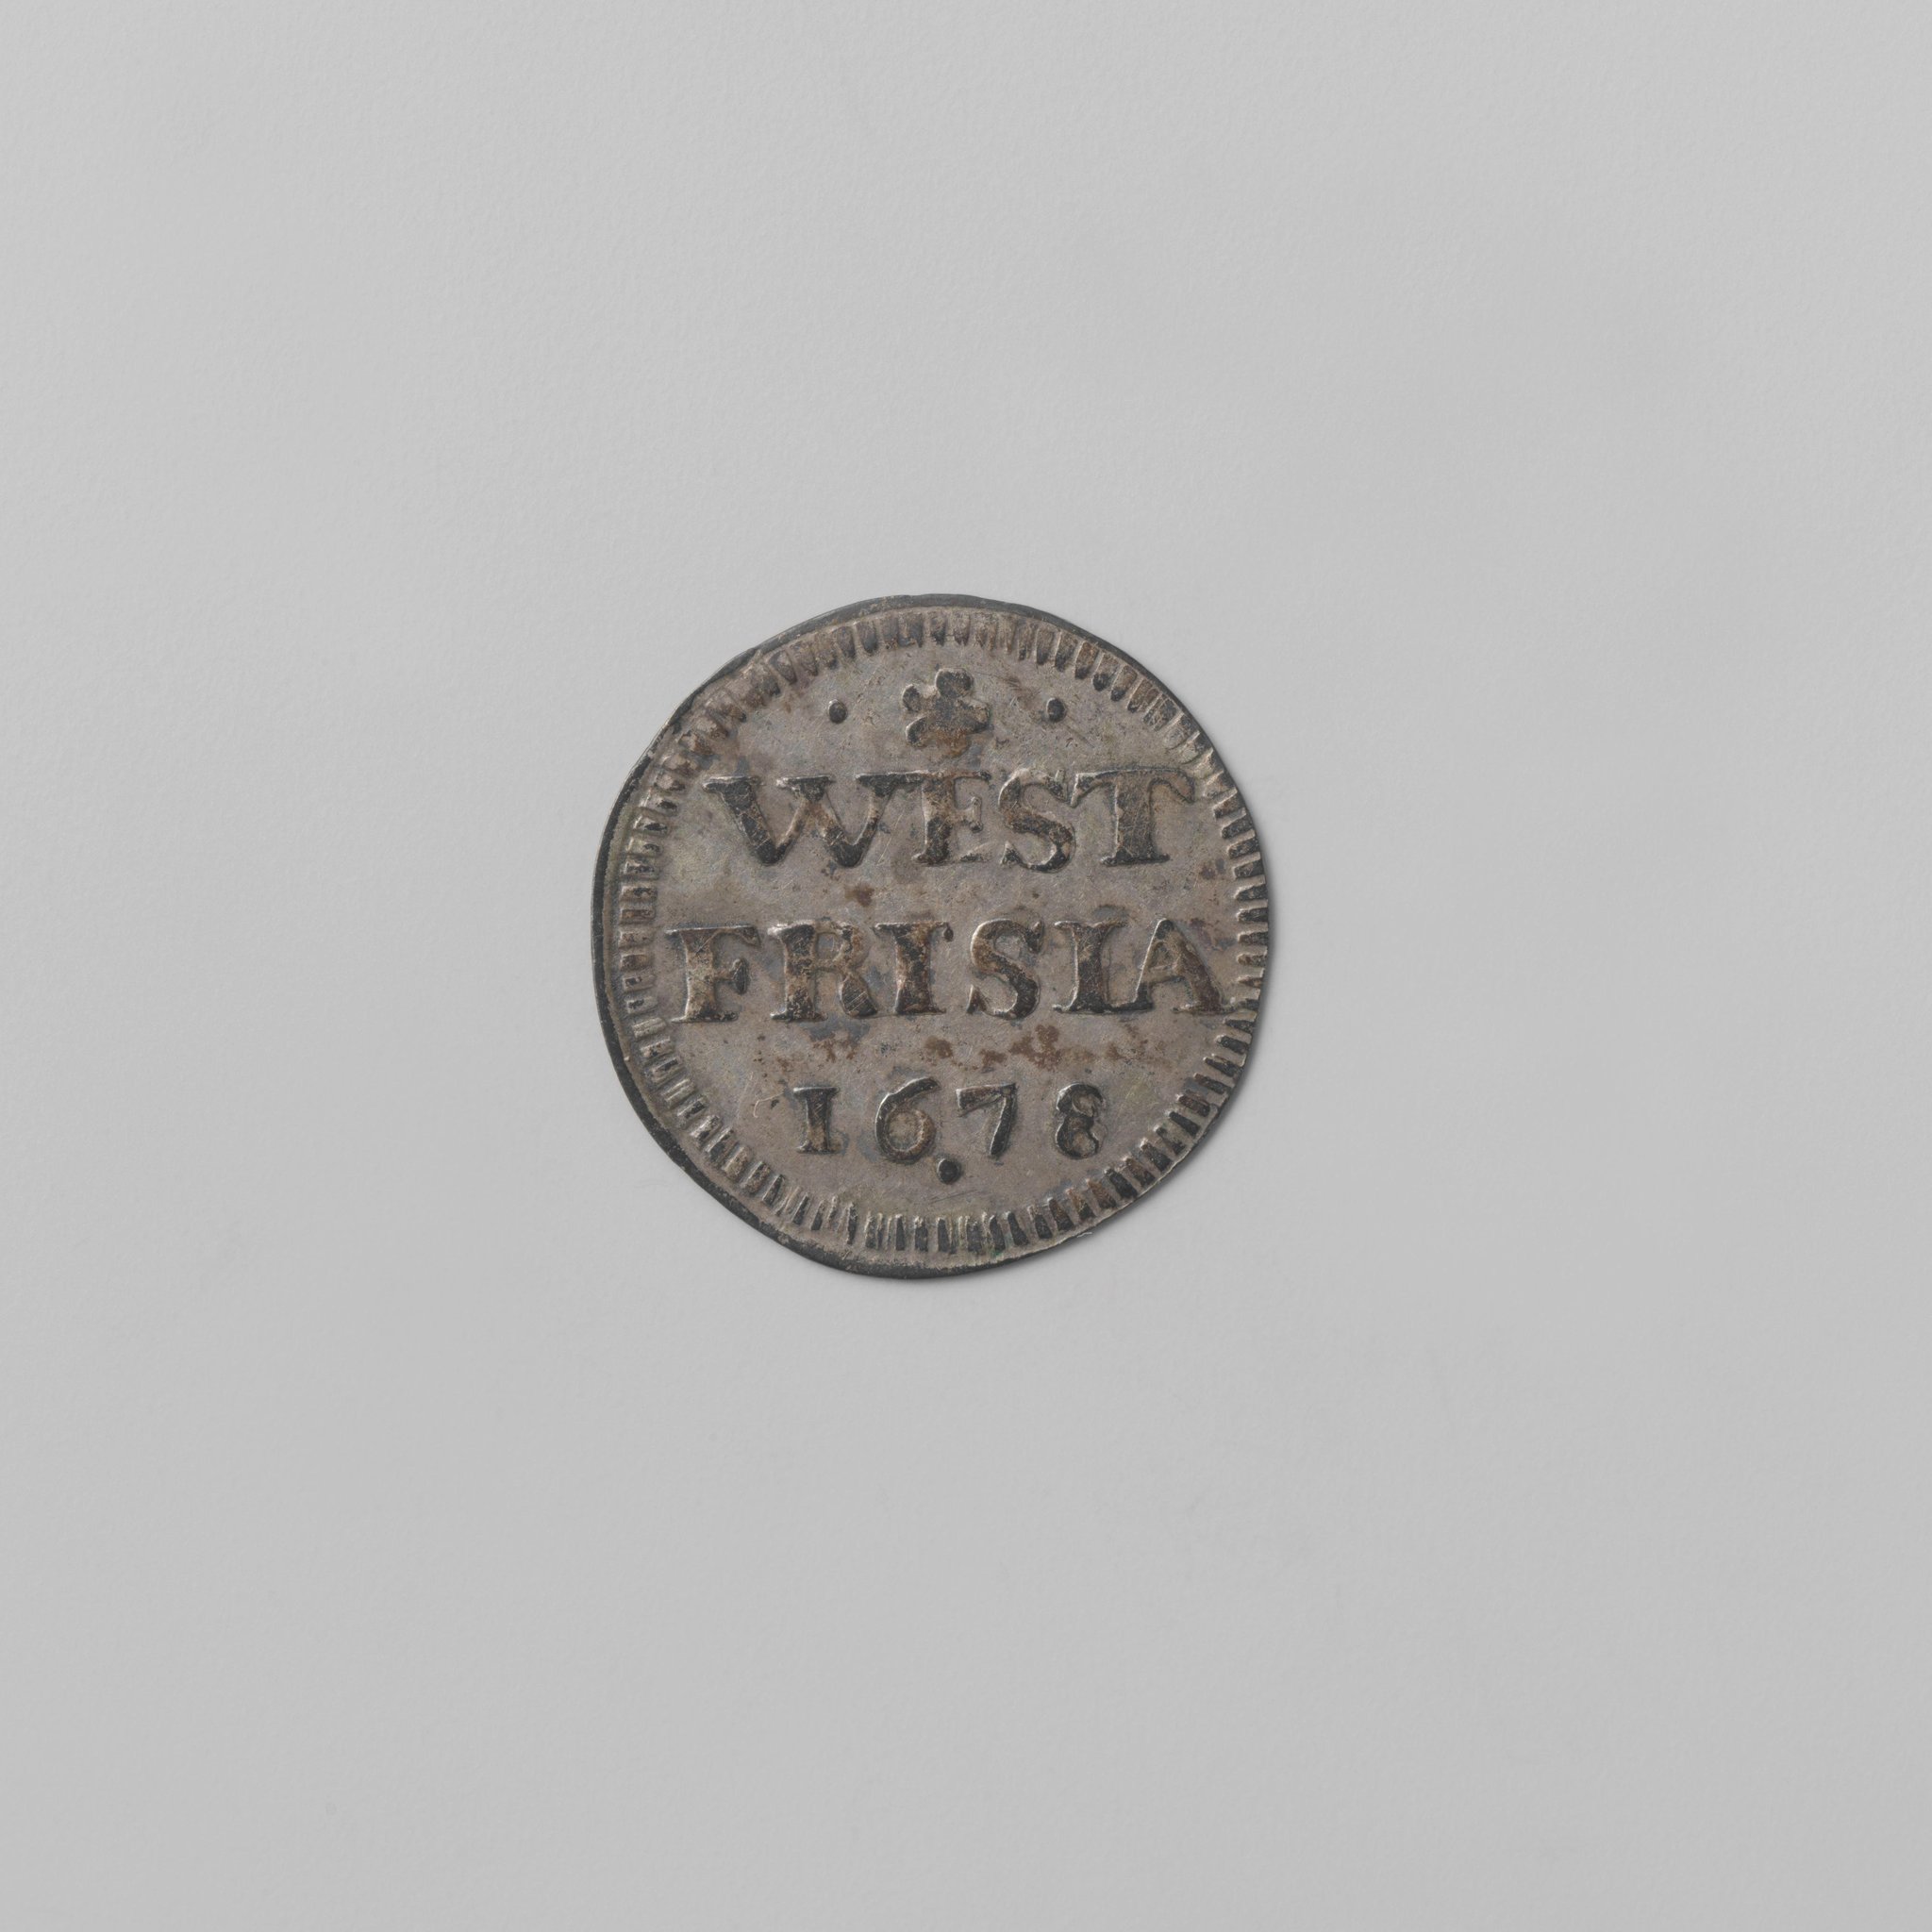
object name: coin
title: West-Friesland, stuiver, 1678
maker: dirck bosch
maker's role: mintmaster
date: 1678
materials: silver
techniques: striking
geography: enkhuizen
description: Zilveren munt. Voorzijde: tussen waarde-aanduiding 1 S gekroond wapenschild van West-Friesland. Keerzijde: Opschrift in twee regels.Daaronder jaartal en een punt. Daarboven een rozet tussen twee punten.